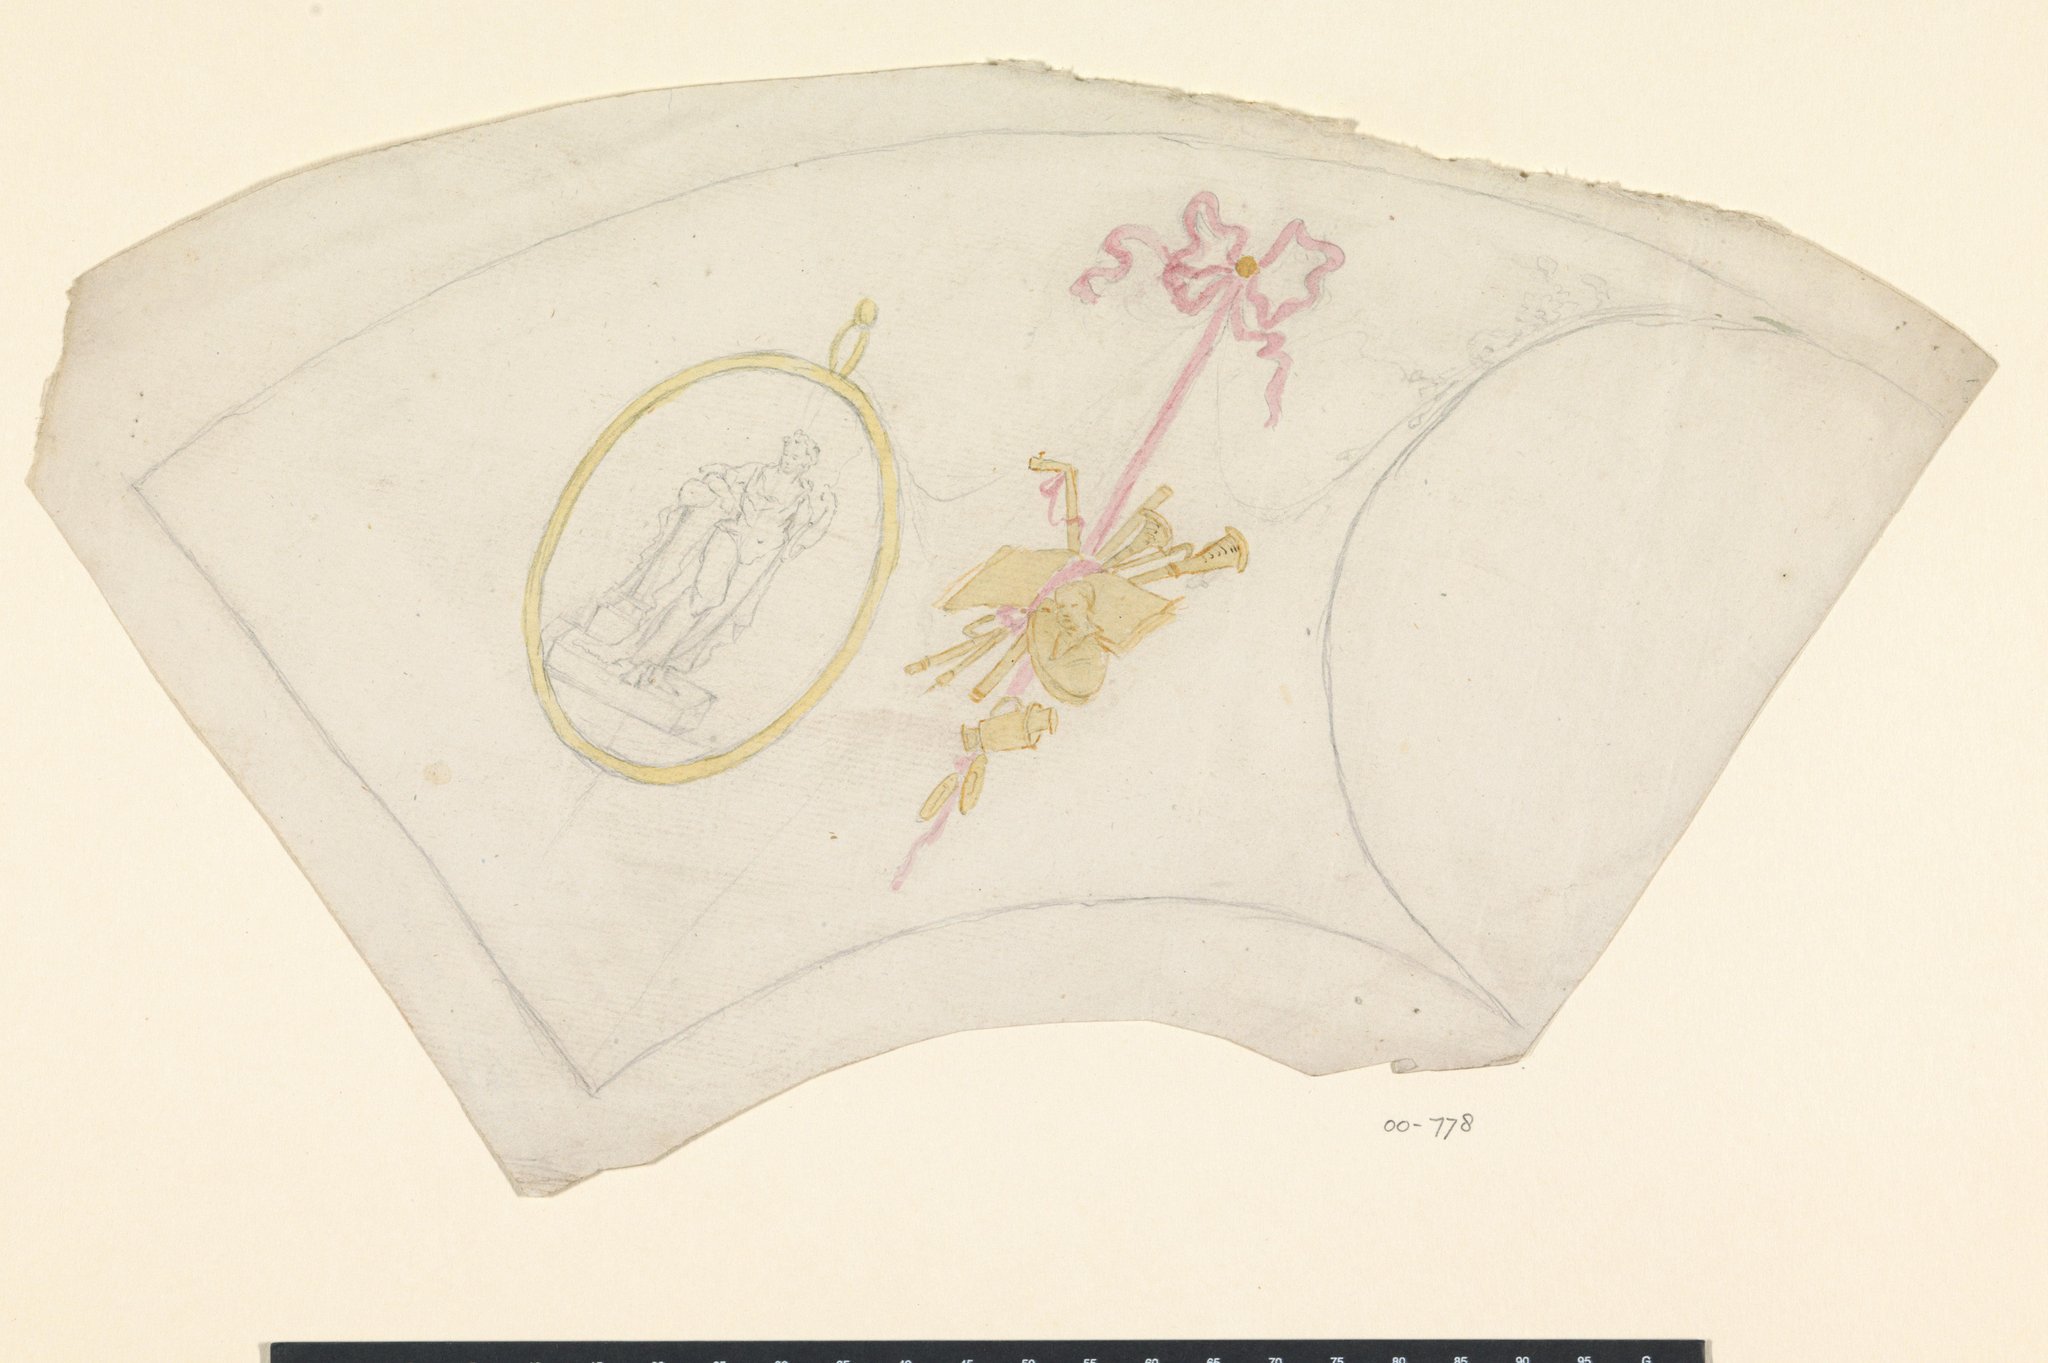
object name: design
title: Medaillon en trofee met muziekinstrumenten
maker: Anonymous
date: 1600-1800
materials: paper, pencil, watercolor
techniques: brush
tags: musical instruments; group of musical instruments, trophy, i.e.: decorative arrangement of symbolic or typical objects ~ ornament, ornament ~ medallion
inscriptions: collector's mark: Lugt 2228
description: Een waaierblad met een medaillon met een staande figuur en een trofee met muziekinstrumenten.